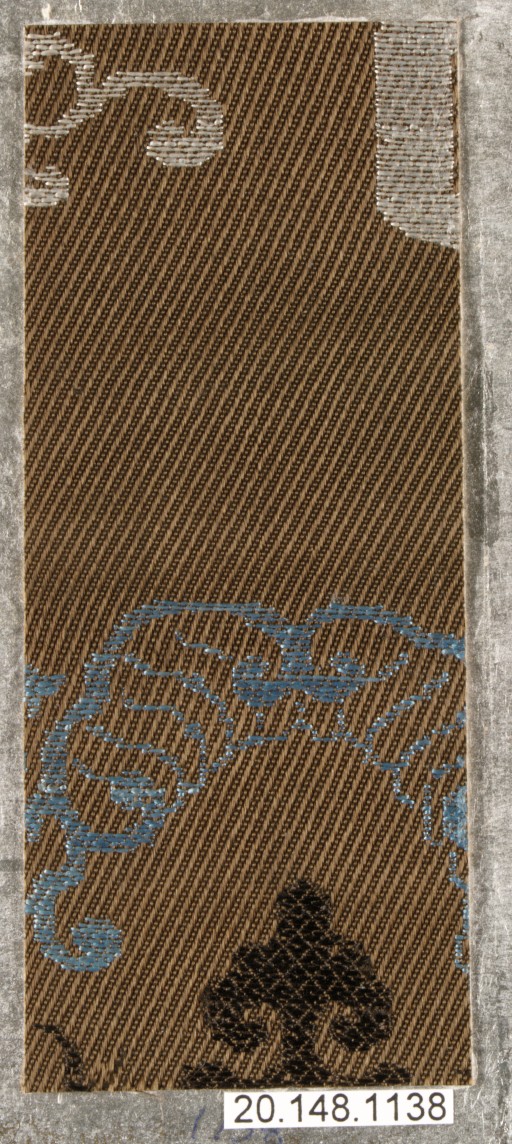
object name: piece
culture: japanese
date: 1801-1900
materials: silk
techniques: compound weave